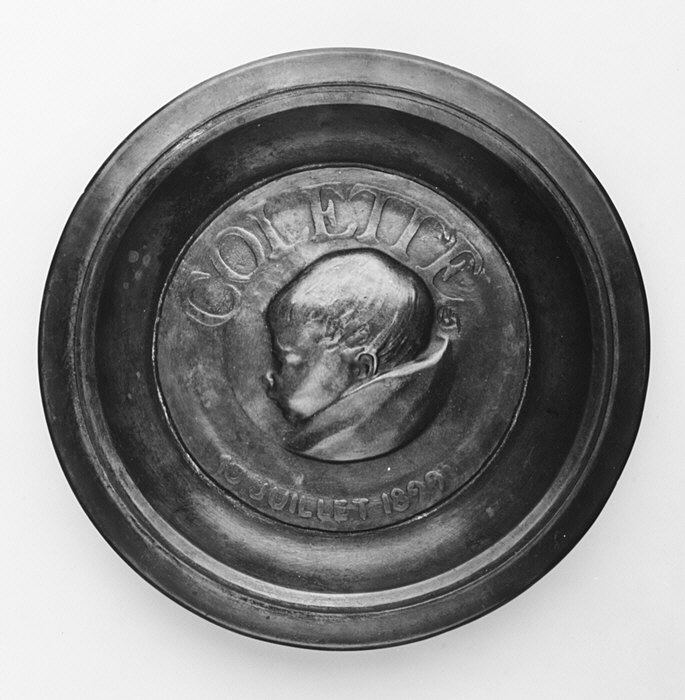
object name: bowl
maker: alexandre-louis-marie charpentier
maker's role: artist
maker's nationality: french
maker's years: 1856-1909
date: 1899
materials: bronze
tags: profiles